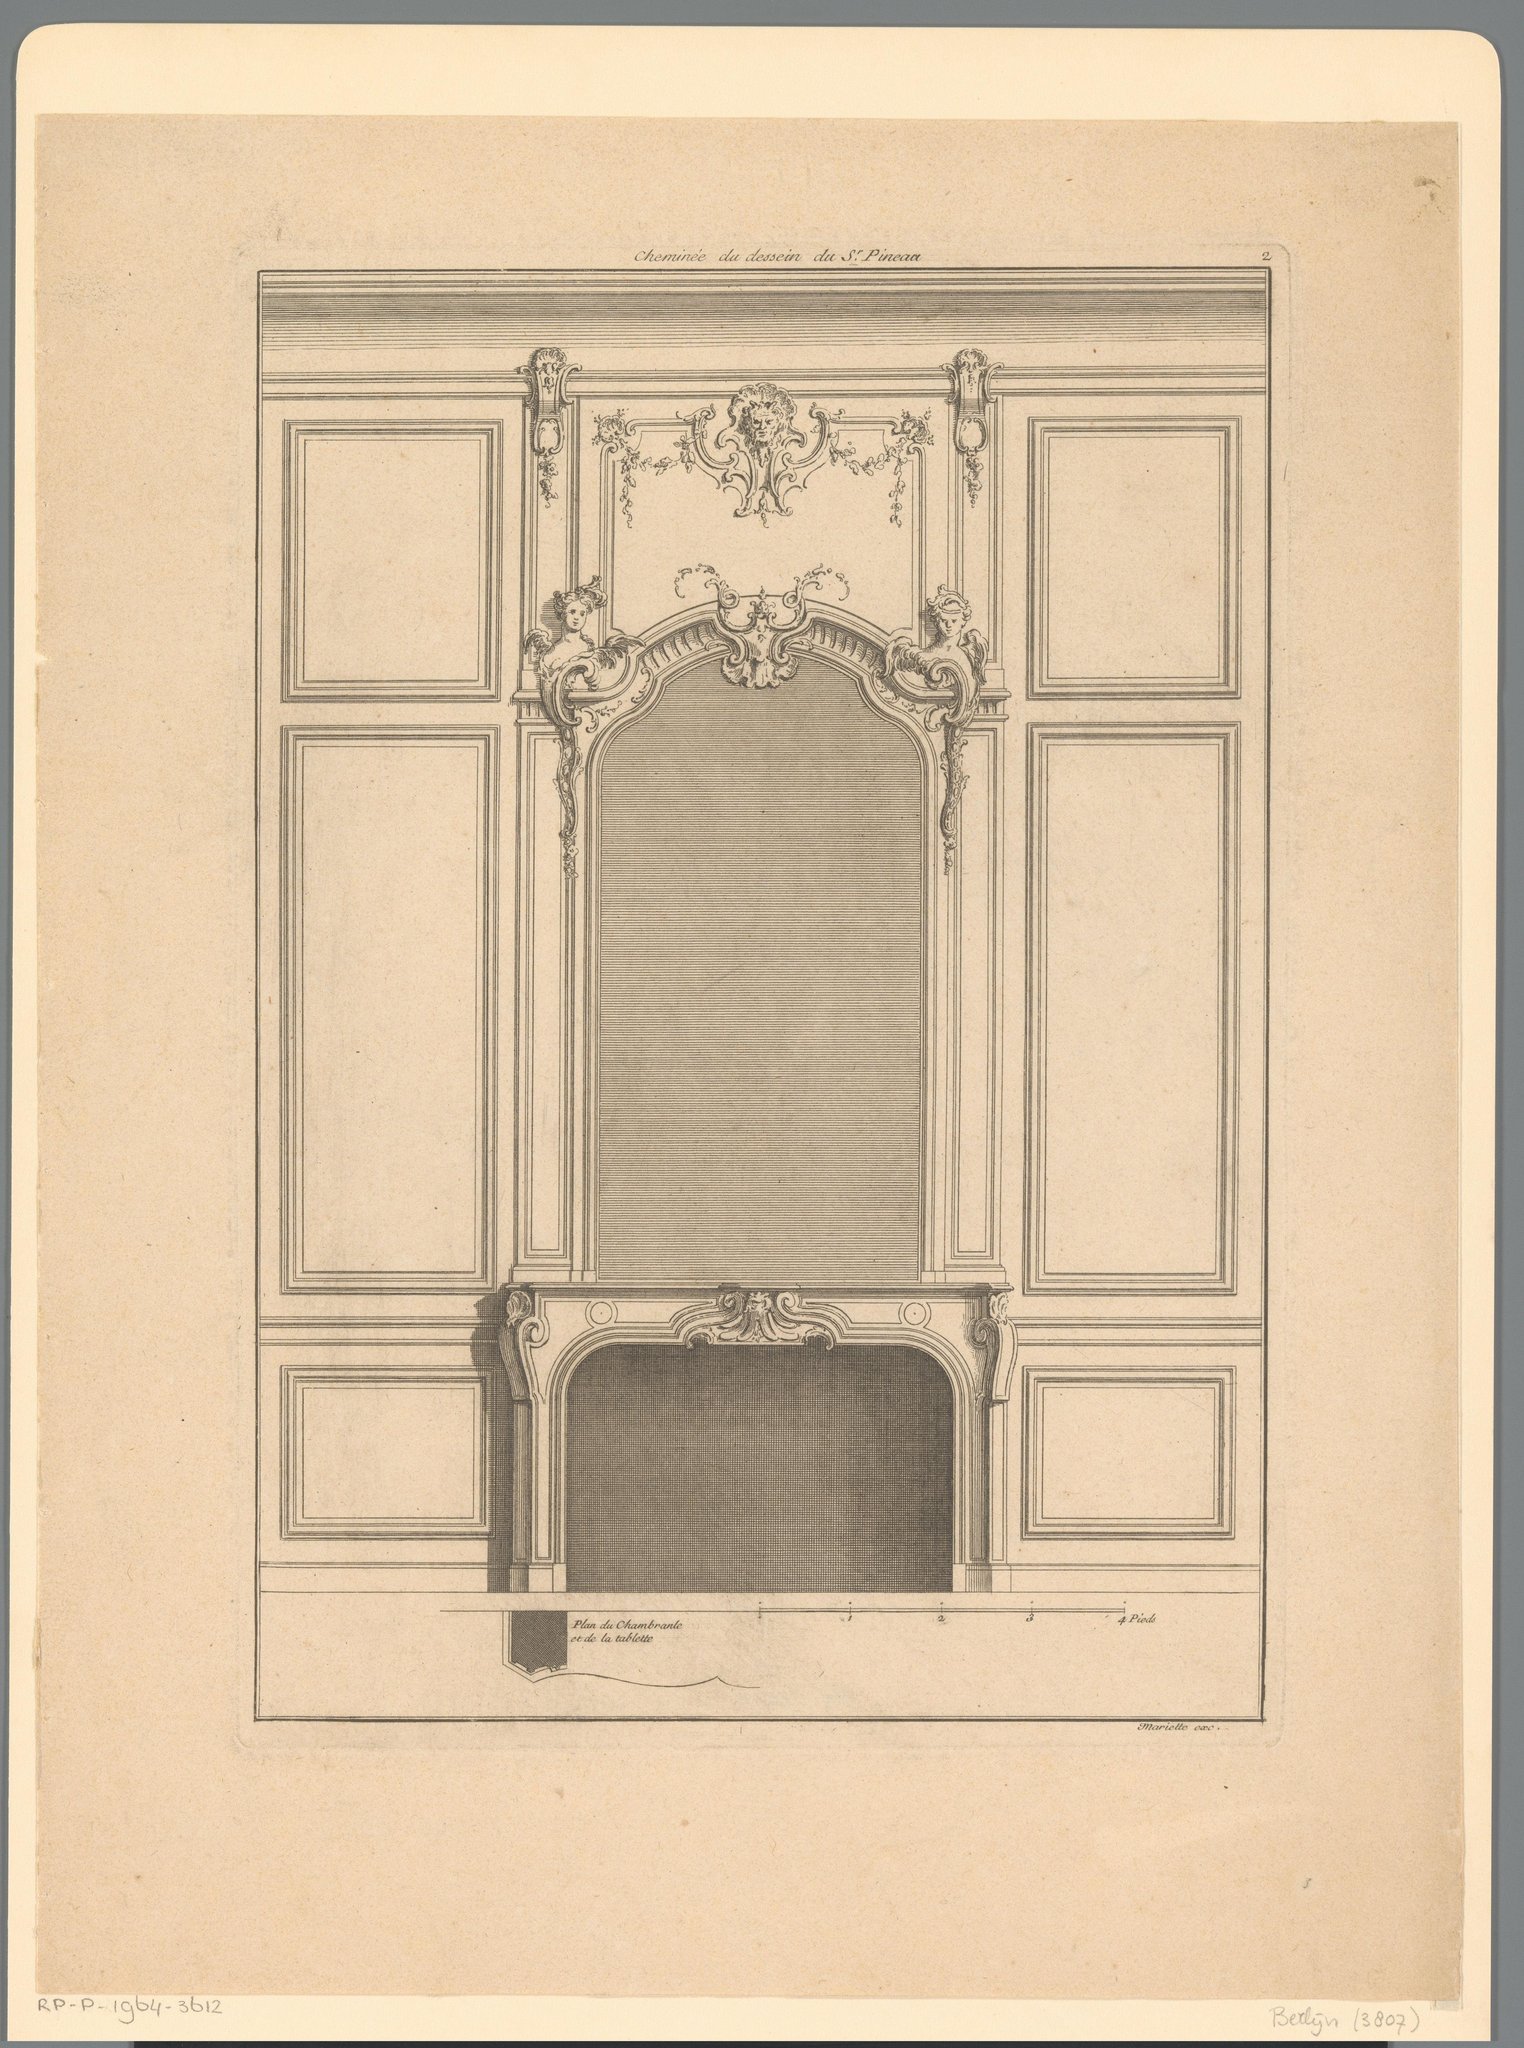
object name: print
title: Schouwen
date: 1694-1742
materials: paper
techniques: engraving, etching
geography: paris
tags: rocaille ornament, open hearth, fire-place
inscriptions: collector's mark: Lugt 2228, collector's mark: Lugt 2760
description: Een geornamenteerde schouw met rocaille ornamenten. Aan de bovenzijde twee gevleugelde halffiguren, rocailles en een saterkop.